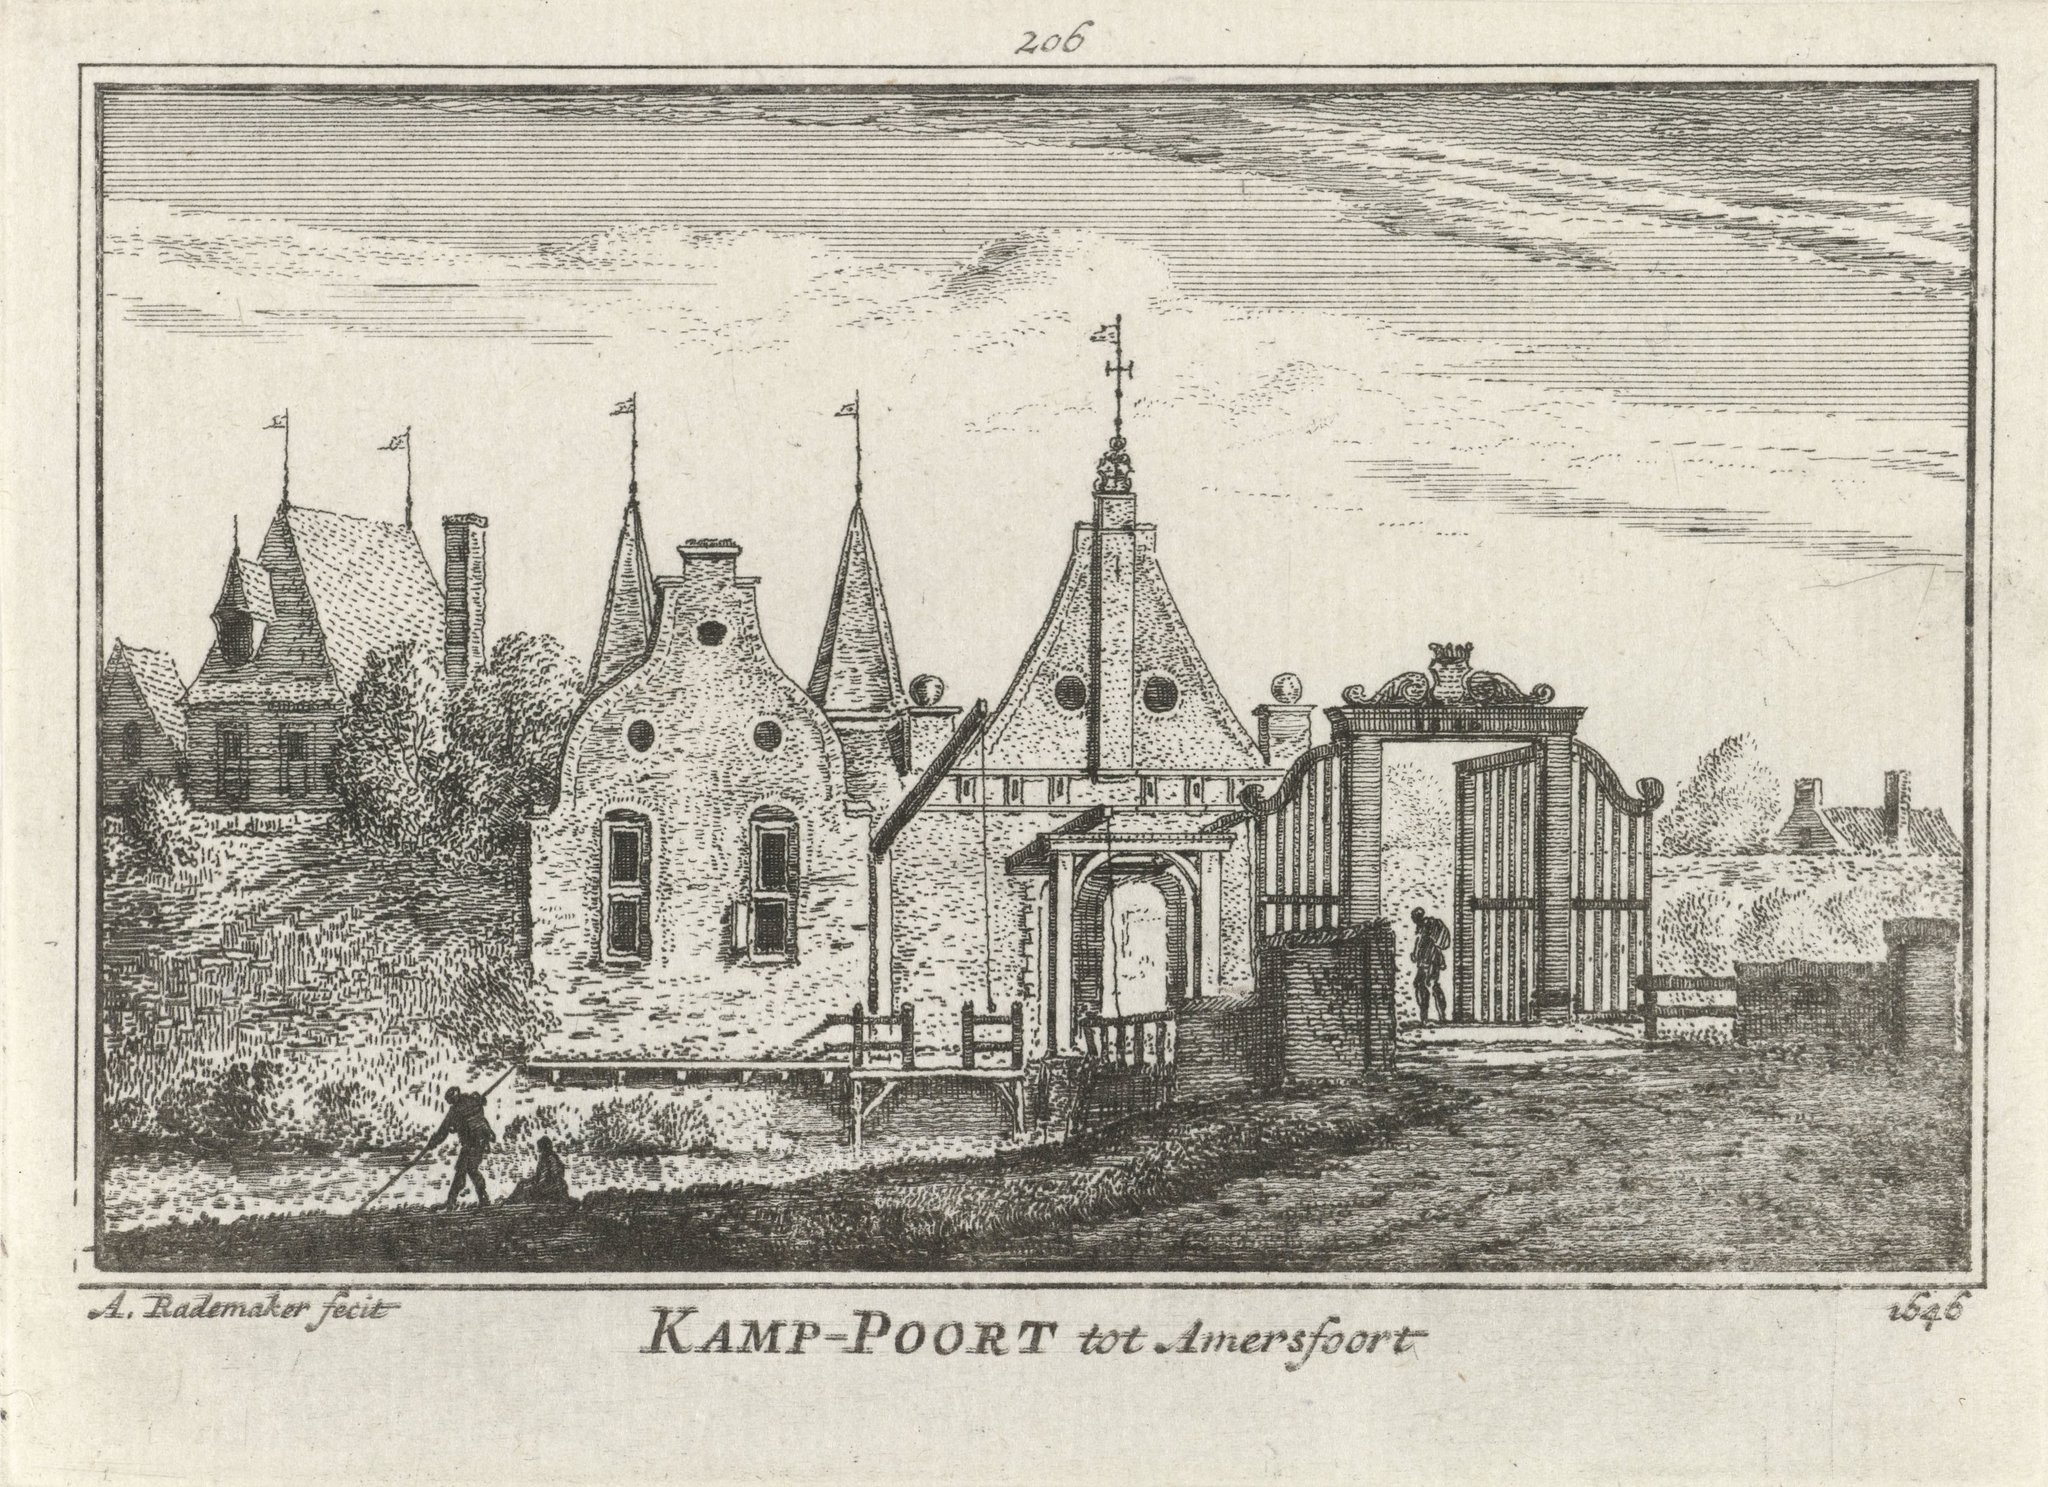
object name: print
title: Gezicht op de Kamperbuitenpoort te Amersfoort, 1646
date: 1727-1733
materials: paper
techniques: engraving, etching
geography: amsterdam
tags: city-gate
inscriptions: collector's mark: Lugt 2228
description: Illustratie uit: Abraham Rademaker, Matthaeus Brouërius van Niedek, Isaac Le Long, Kabinet van Nederlandsche en Kleefsche outheden en (...) voorname stads- en landgebouwen, Willem Barents en Antoni Schoonenburg: Amsterdam, 1727-1733, ill. nr. 206.